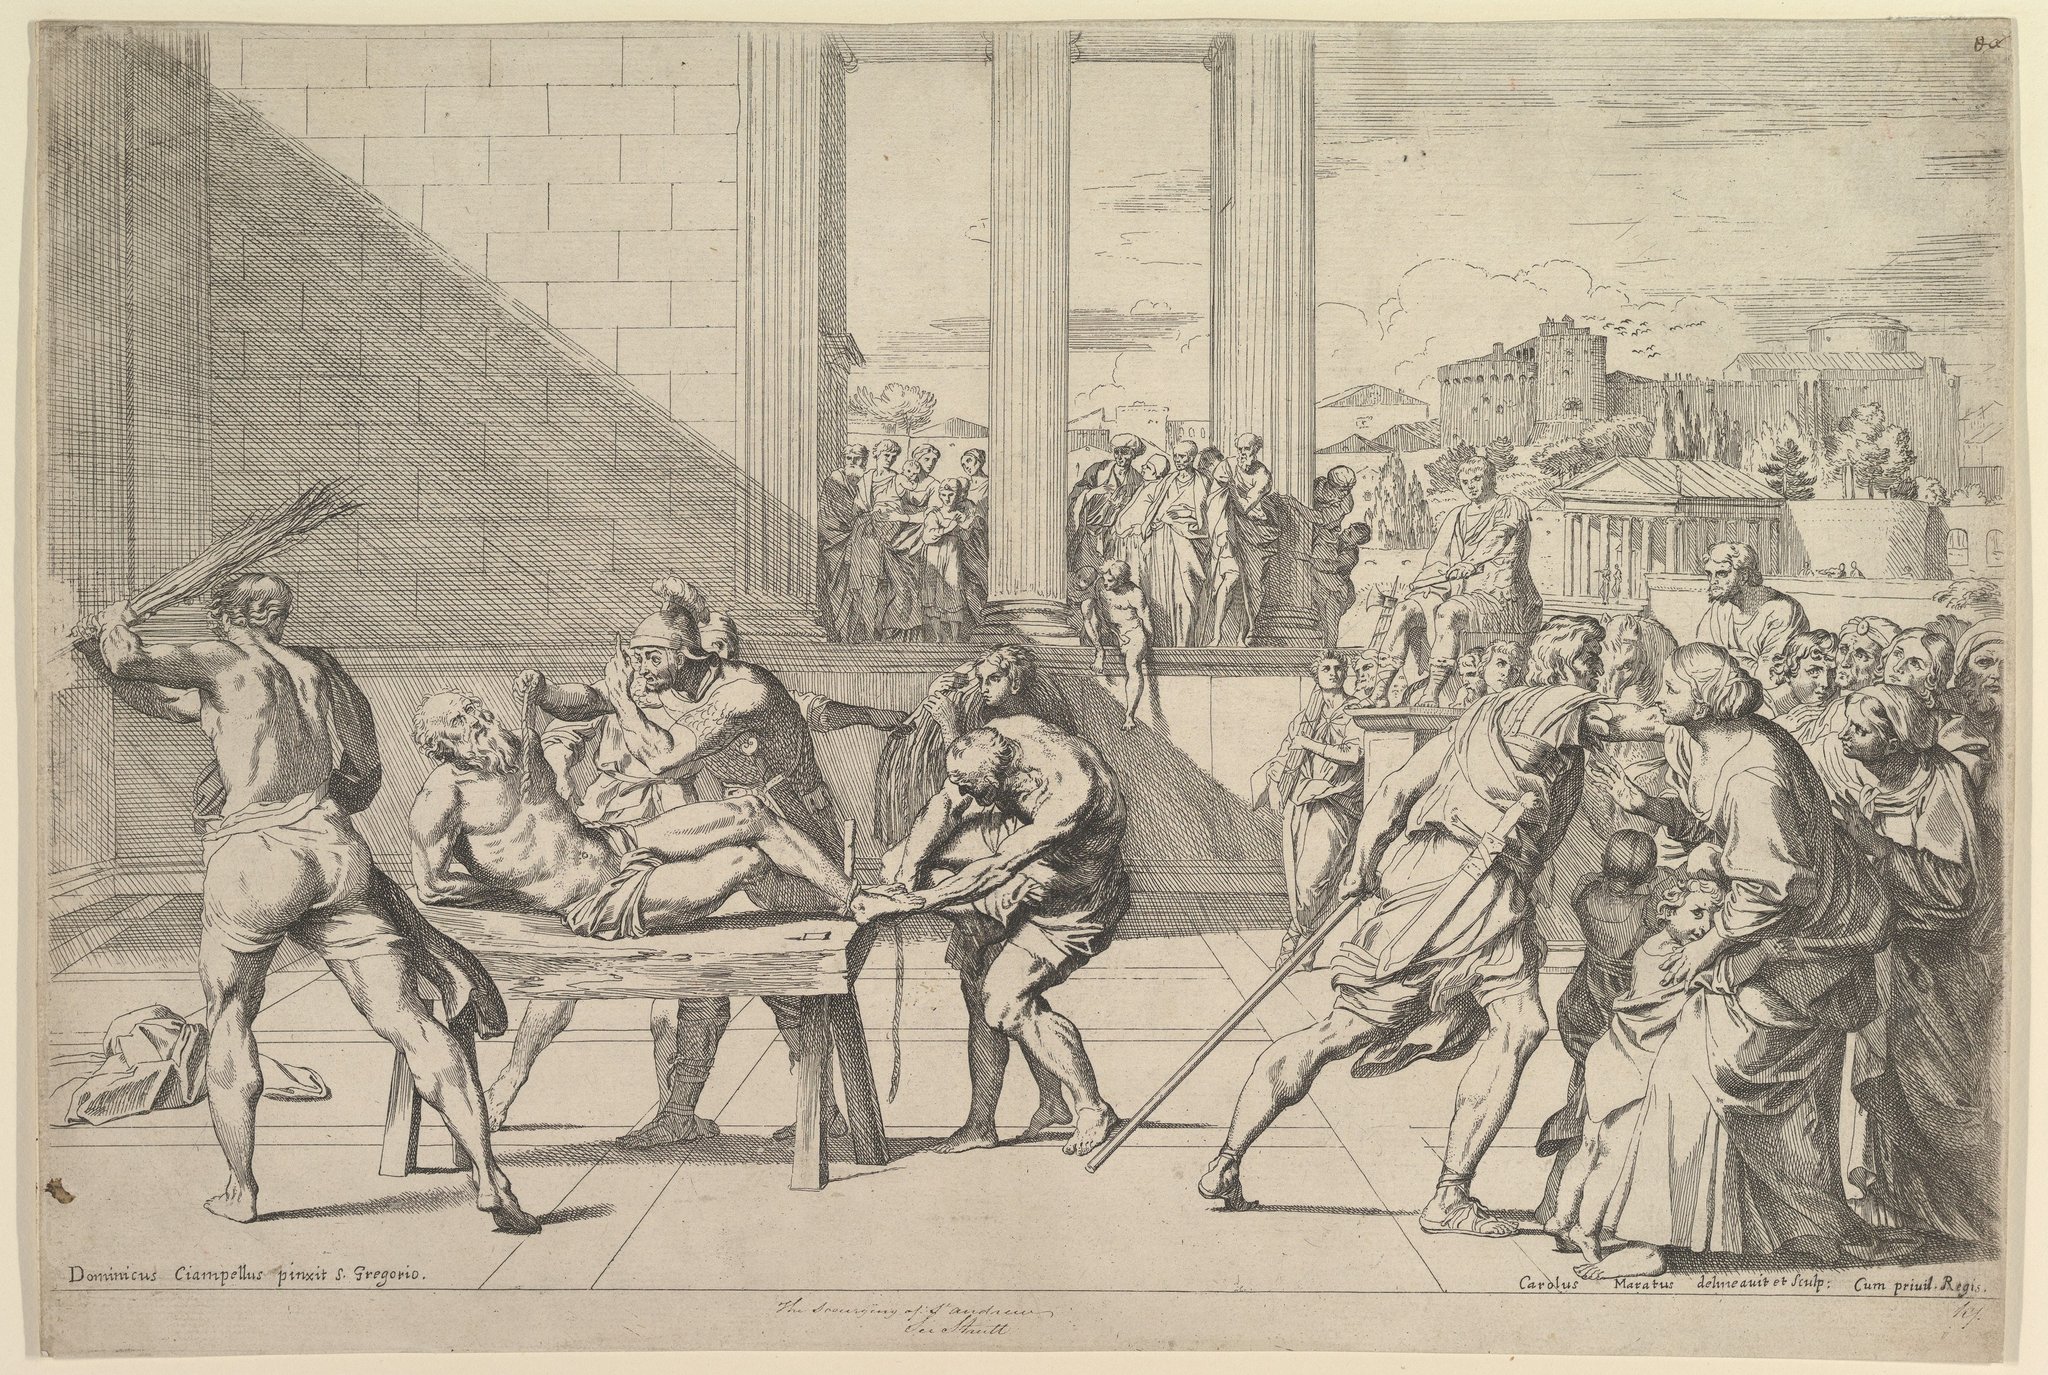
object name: print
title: The Martyrdom of Saint Andrew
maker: carlo maratti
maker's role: artist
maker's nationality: italian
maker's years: 1625-1713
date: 1645-1670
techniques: etching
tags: suffering,men,saints,crowd,execution